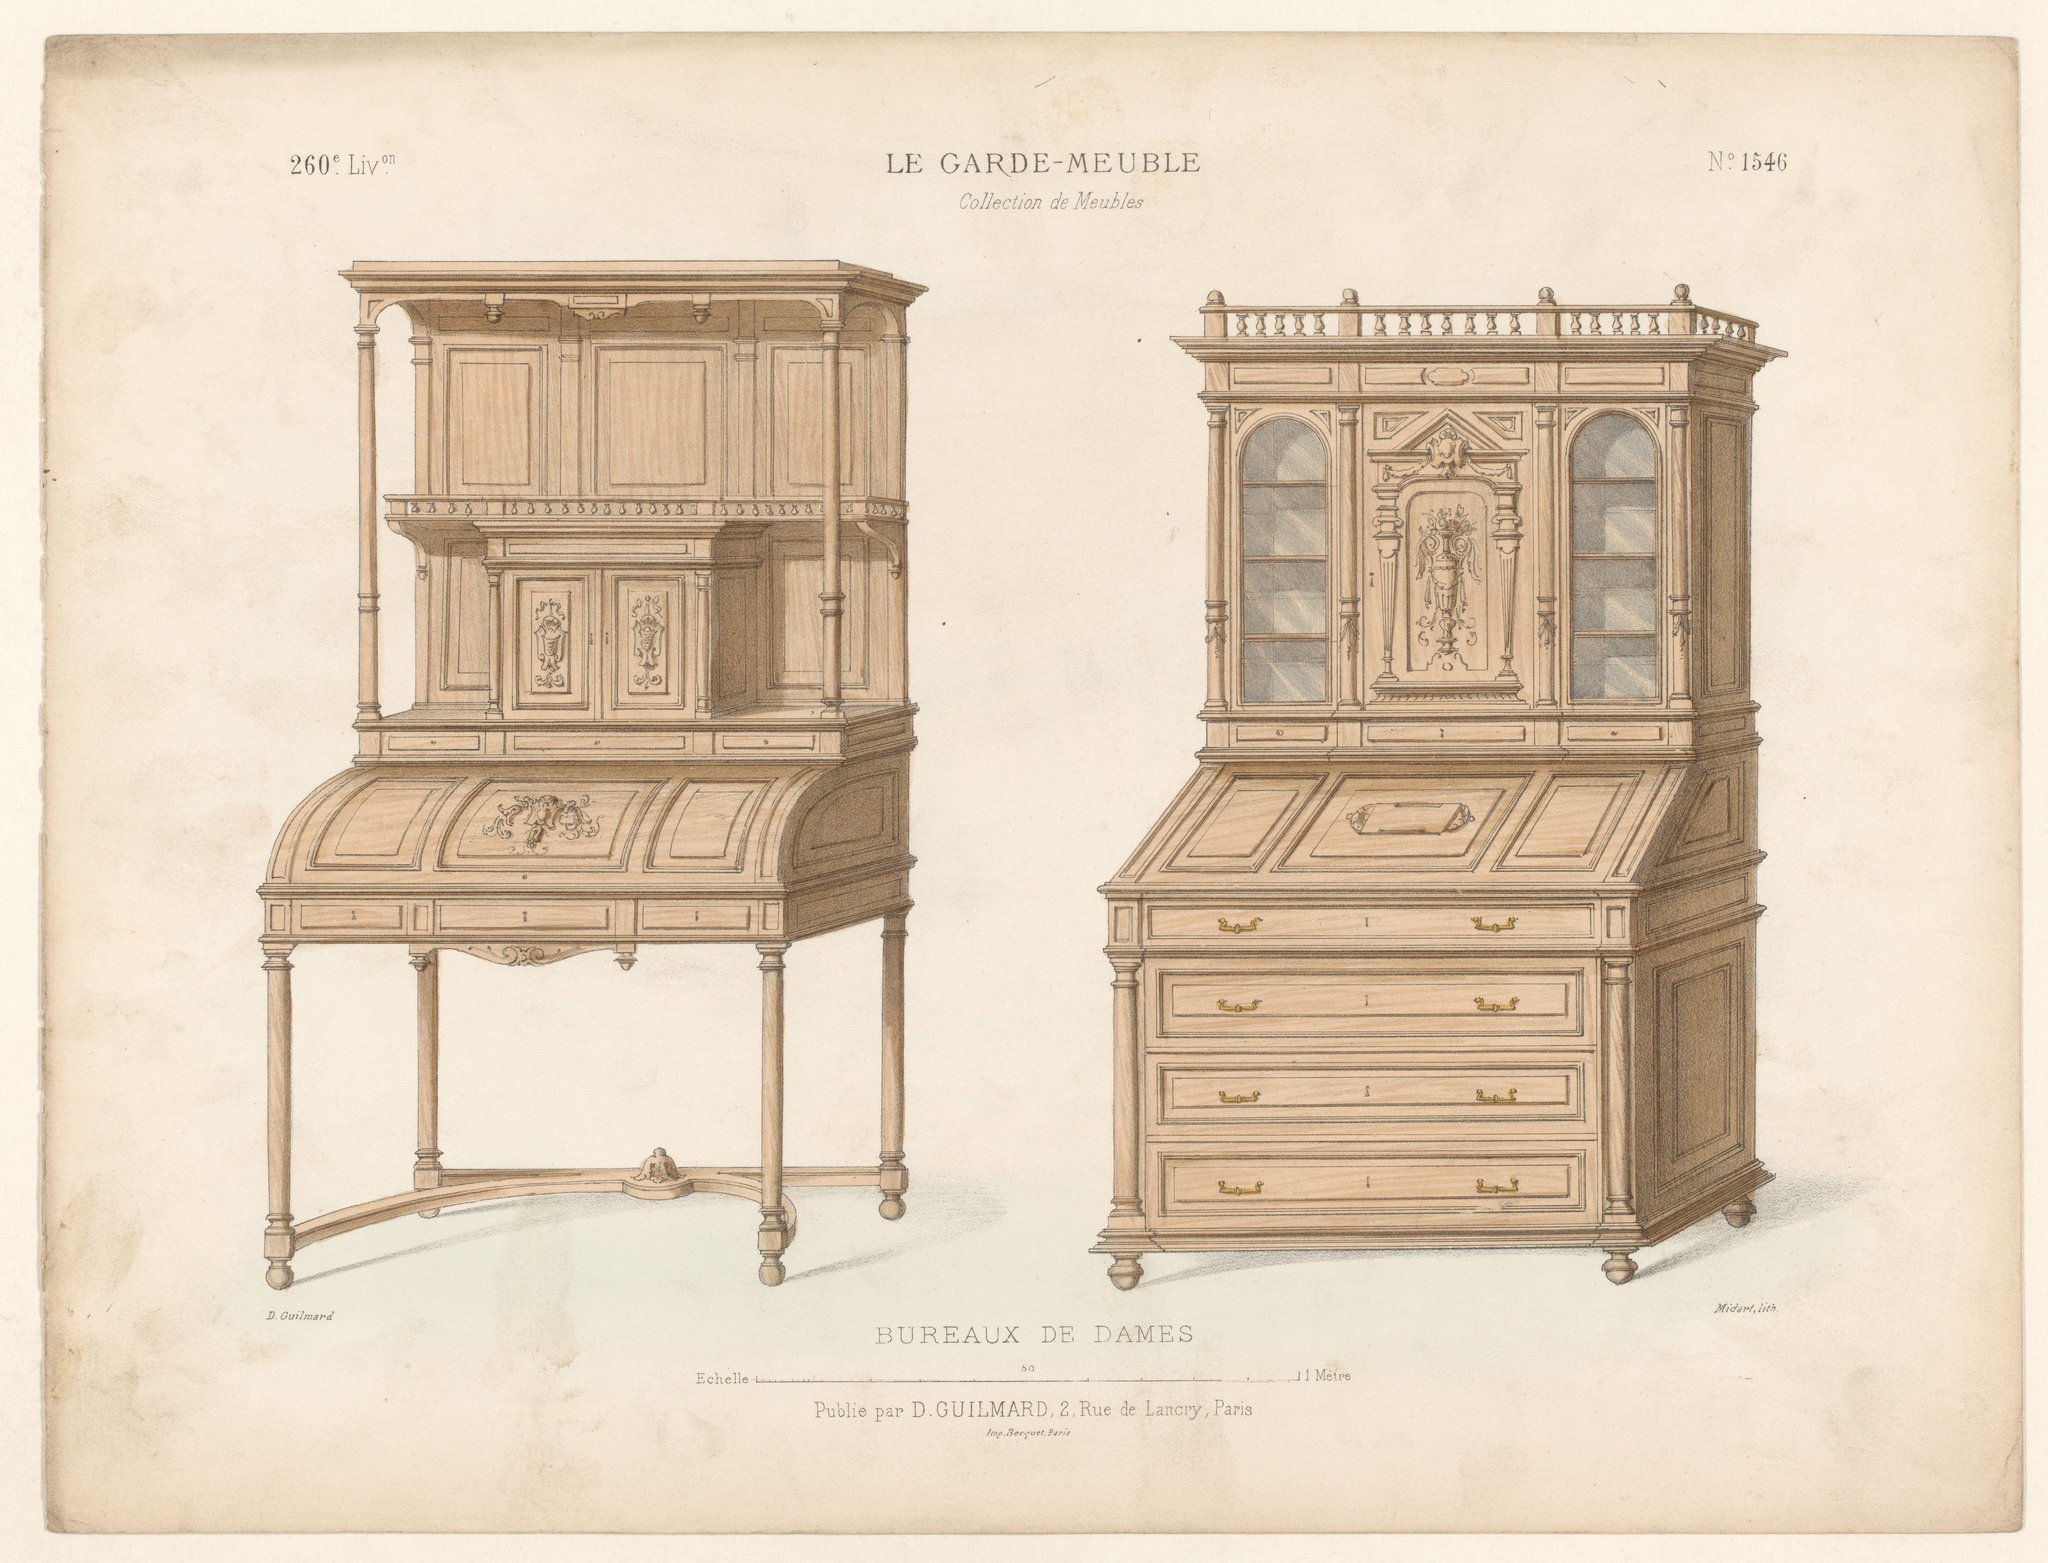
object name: print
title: Bureaux de dames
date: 1839-1885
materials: paper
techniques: hand coloring, lithograph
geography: paris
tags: writing-table, writing-desk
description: Ieder Livraison in de serie Le Garde-Meuble bevat negen platen: drie 'sièges' (zitmeubels), drie 'meubles' (diverse meubels zoals tafels en kasten) en drie 'tentures' (gordijnen en draperieën).